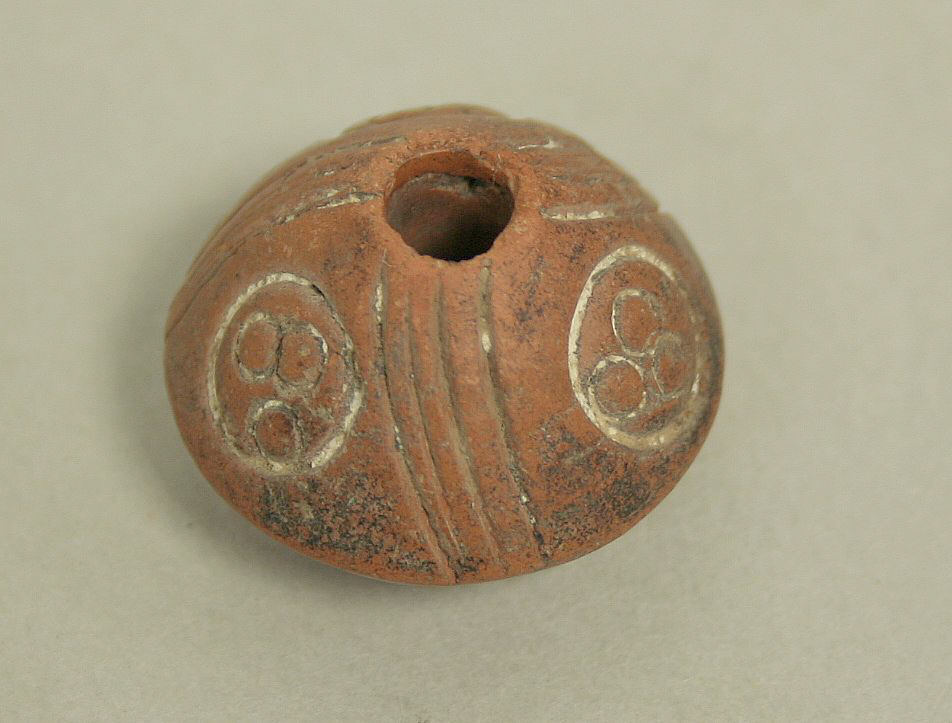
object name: spindle whorl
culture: peruvian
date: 1-500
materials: ceramic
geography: peru